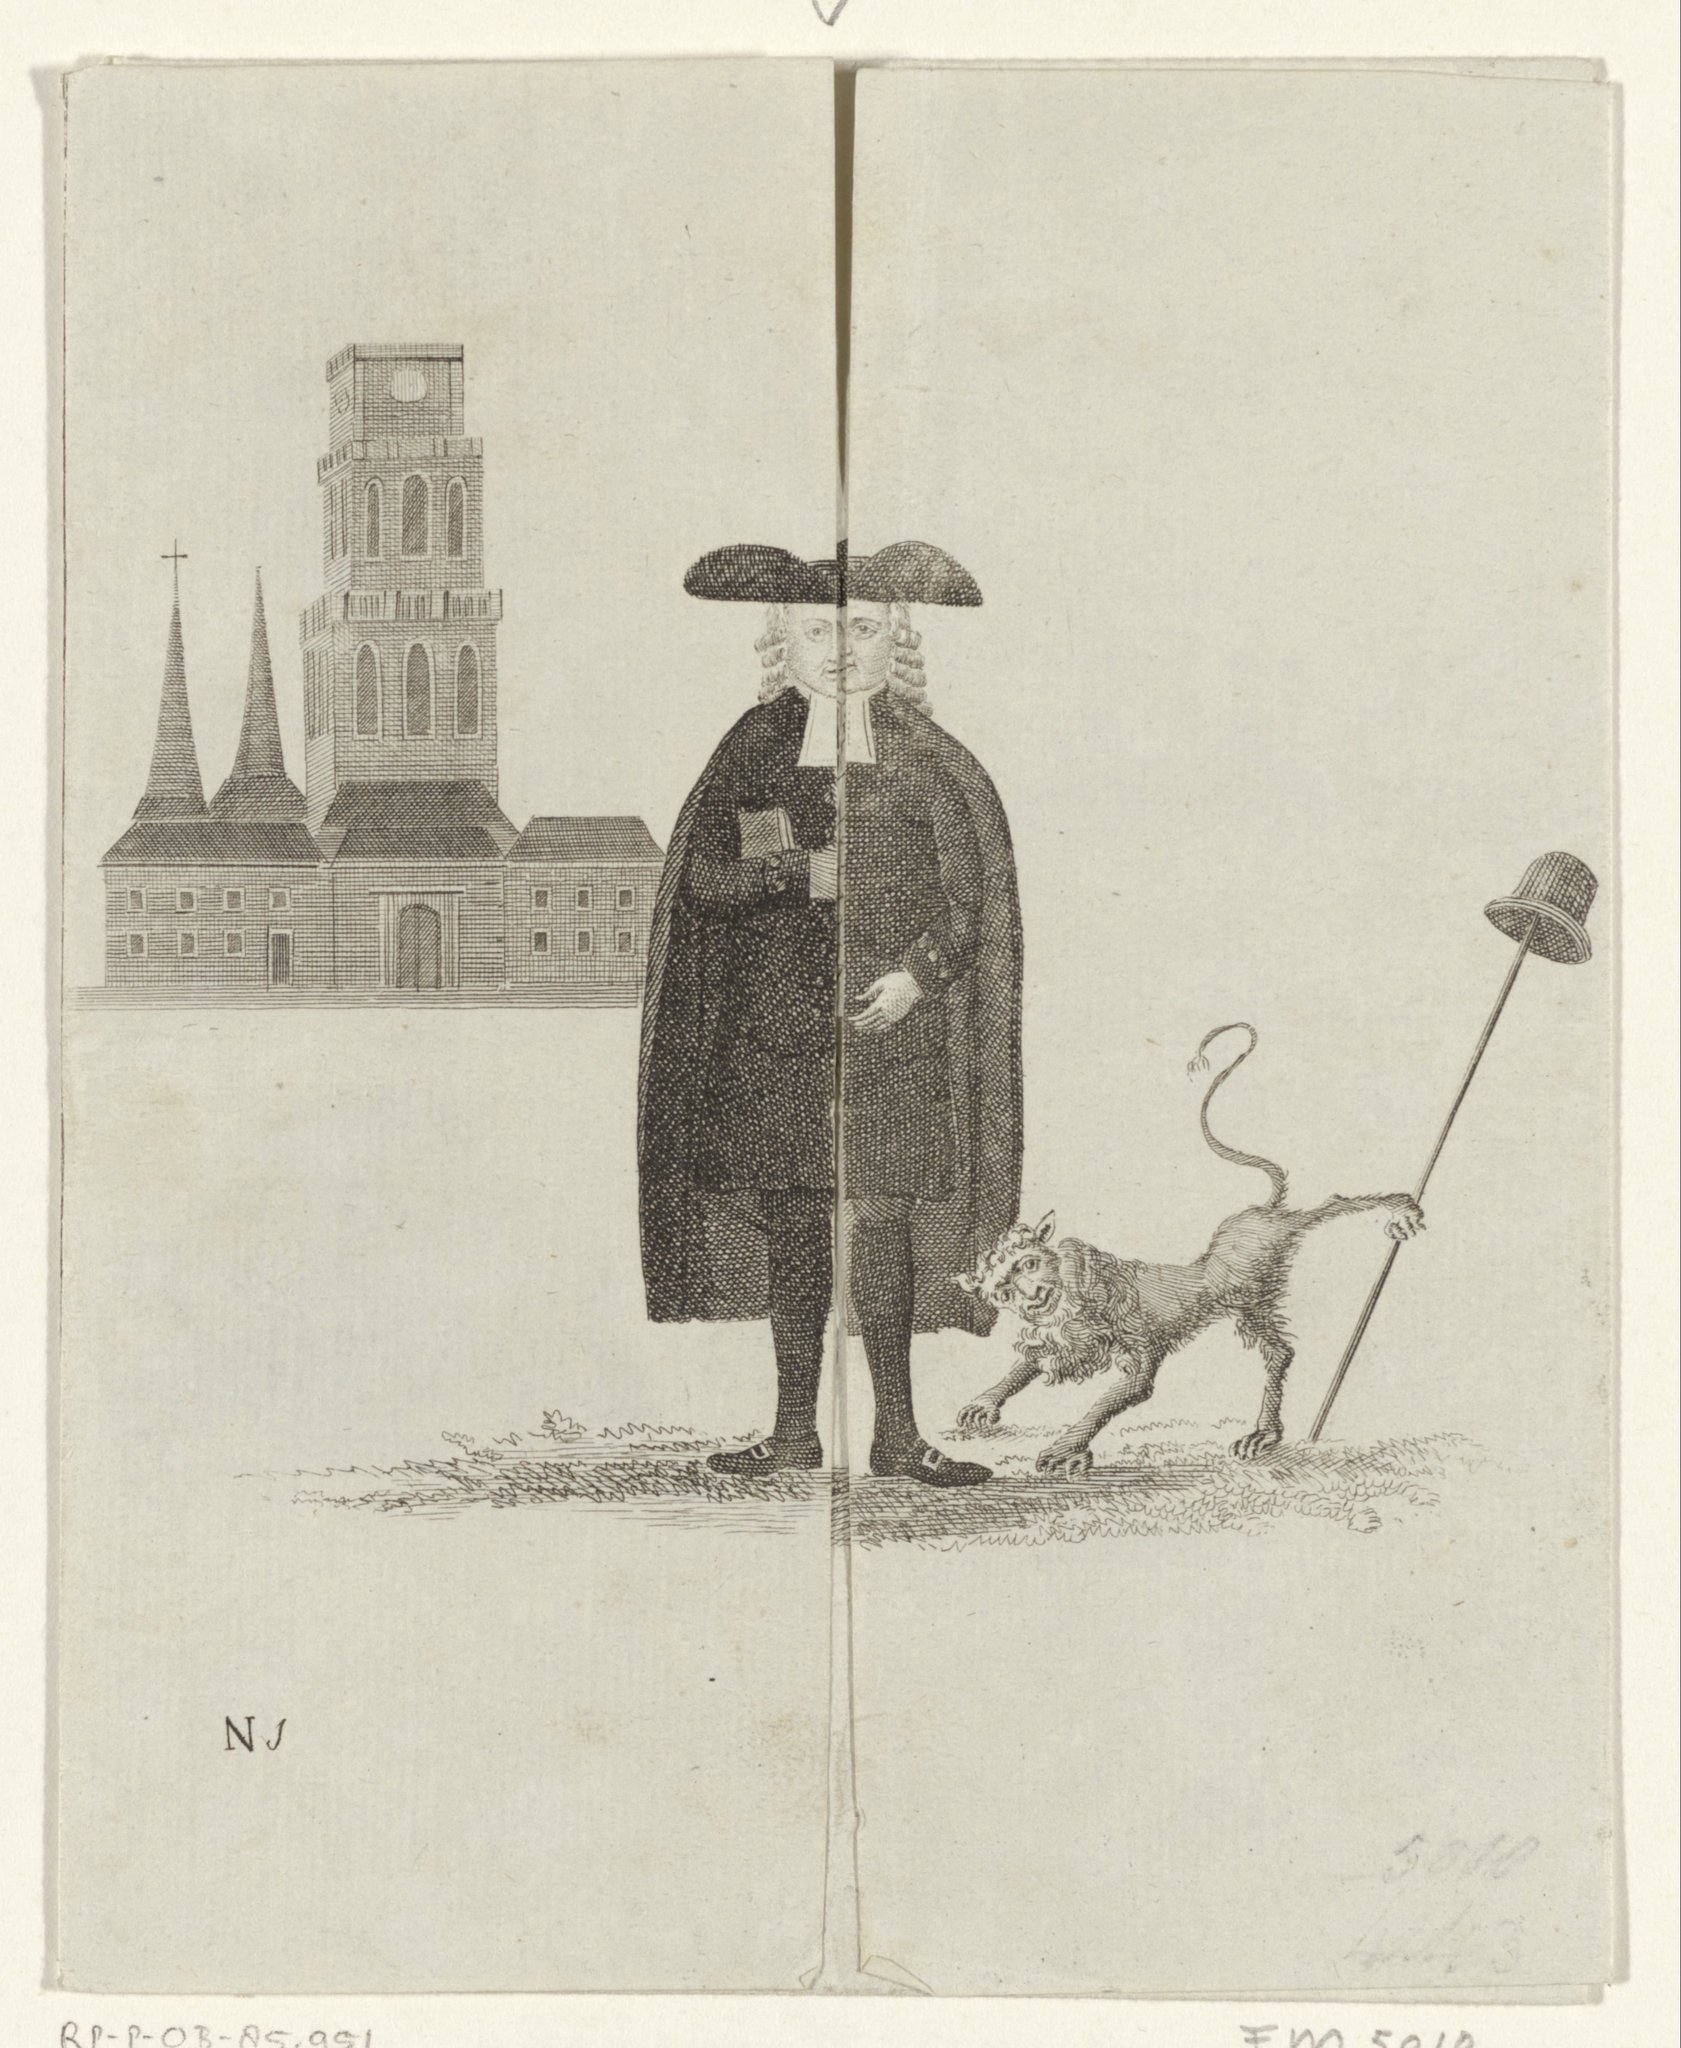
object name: print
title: Spotprent op Johan Jacob le Sage ten Broek, 1787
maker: Anonymous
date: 1787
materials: paper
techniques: engraving, etching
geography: northern netherlands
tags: rotterdam, violent death by hanging, political caricatures and satires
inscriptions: collector's mark: Lugt 2228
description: Spotprent op de, na het herstel van de prins van Oranje, door het Rotterdamse stadsbestuur ontslagen patriotse predikant Johan Jacob le Sage ten Broek, oktober 1787. Openvouwbare prent met vier flappen. Buiten als dominee staande voor de Sint-Laurenskerk te Rotterdam. Binnenin heeft hij zijn domineeskleren uitgedaan en staat hij als vrijkorpist voor de kerk. Tenslotte helemaal binnenin staande in zijn onderkleding op een transparant of doorkijkprent, wanneer tegen het licht gehouden wordt hij door de duivel opgehangen aan de galg. Bij de prent behoren twee afzonderlijke verklaringen.